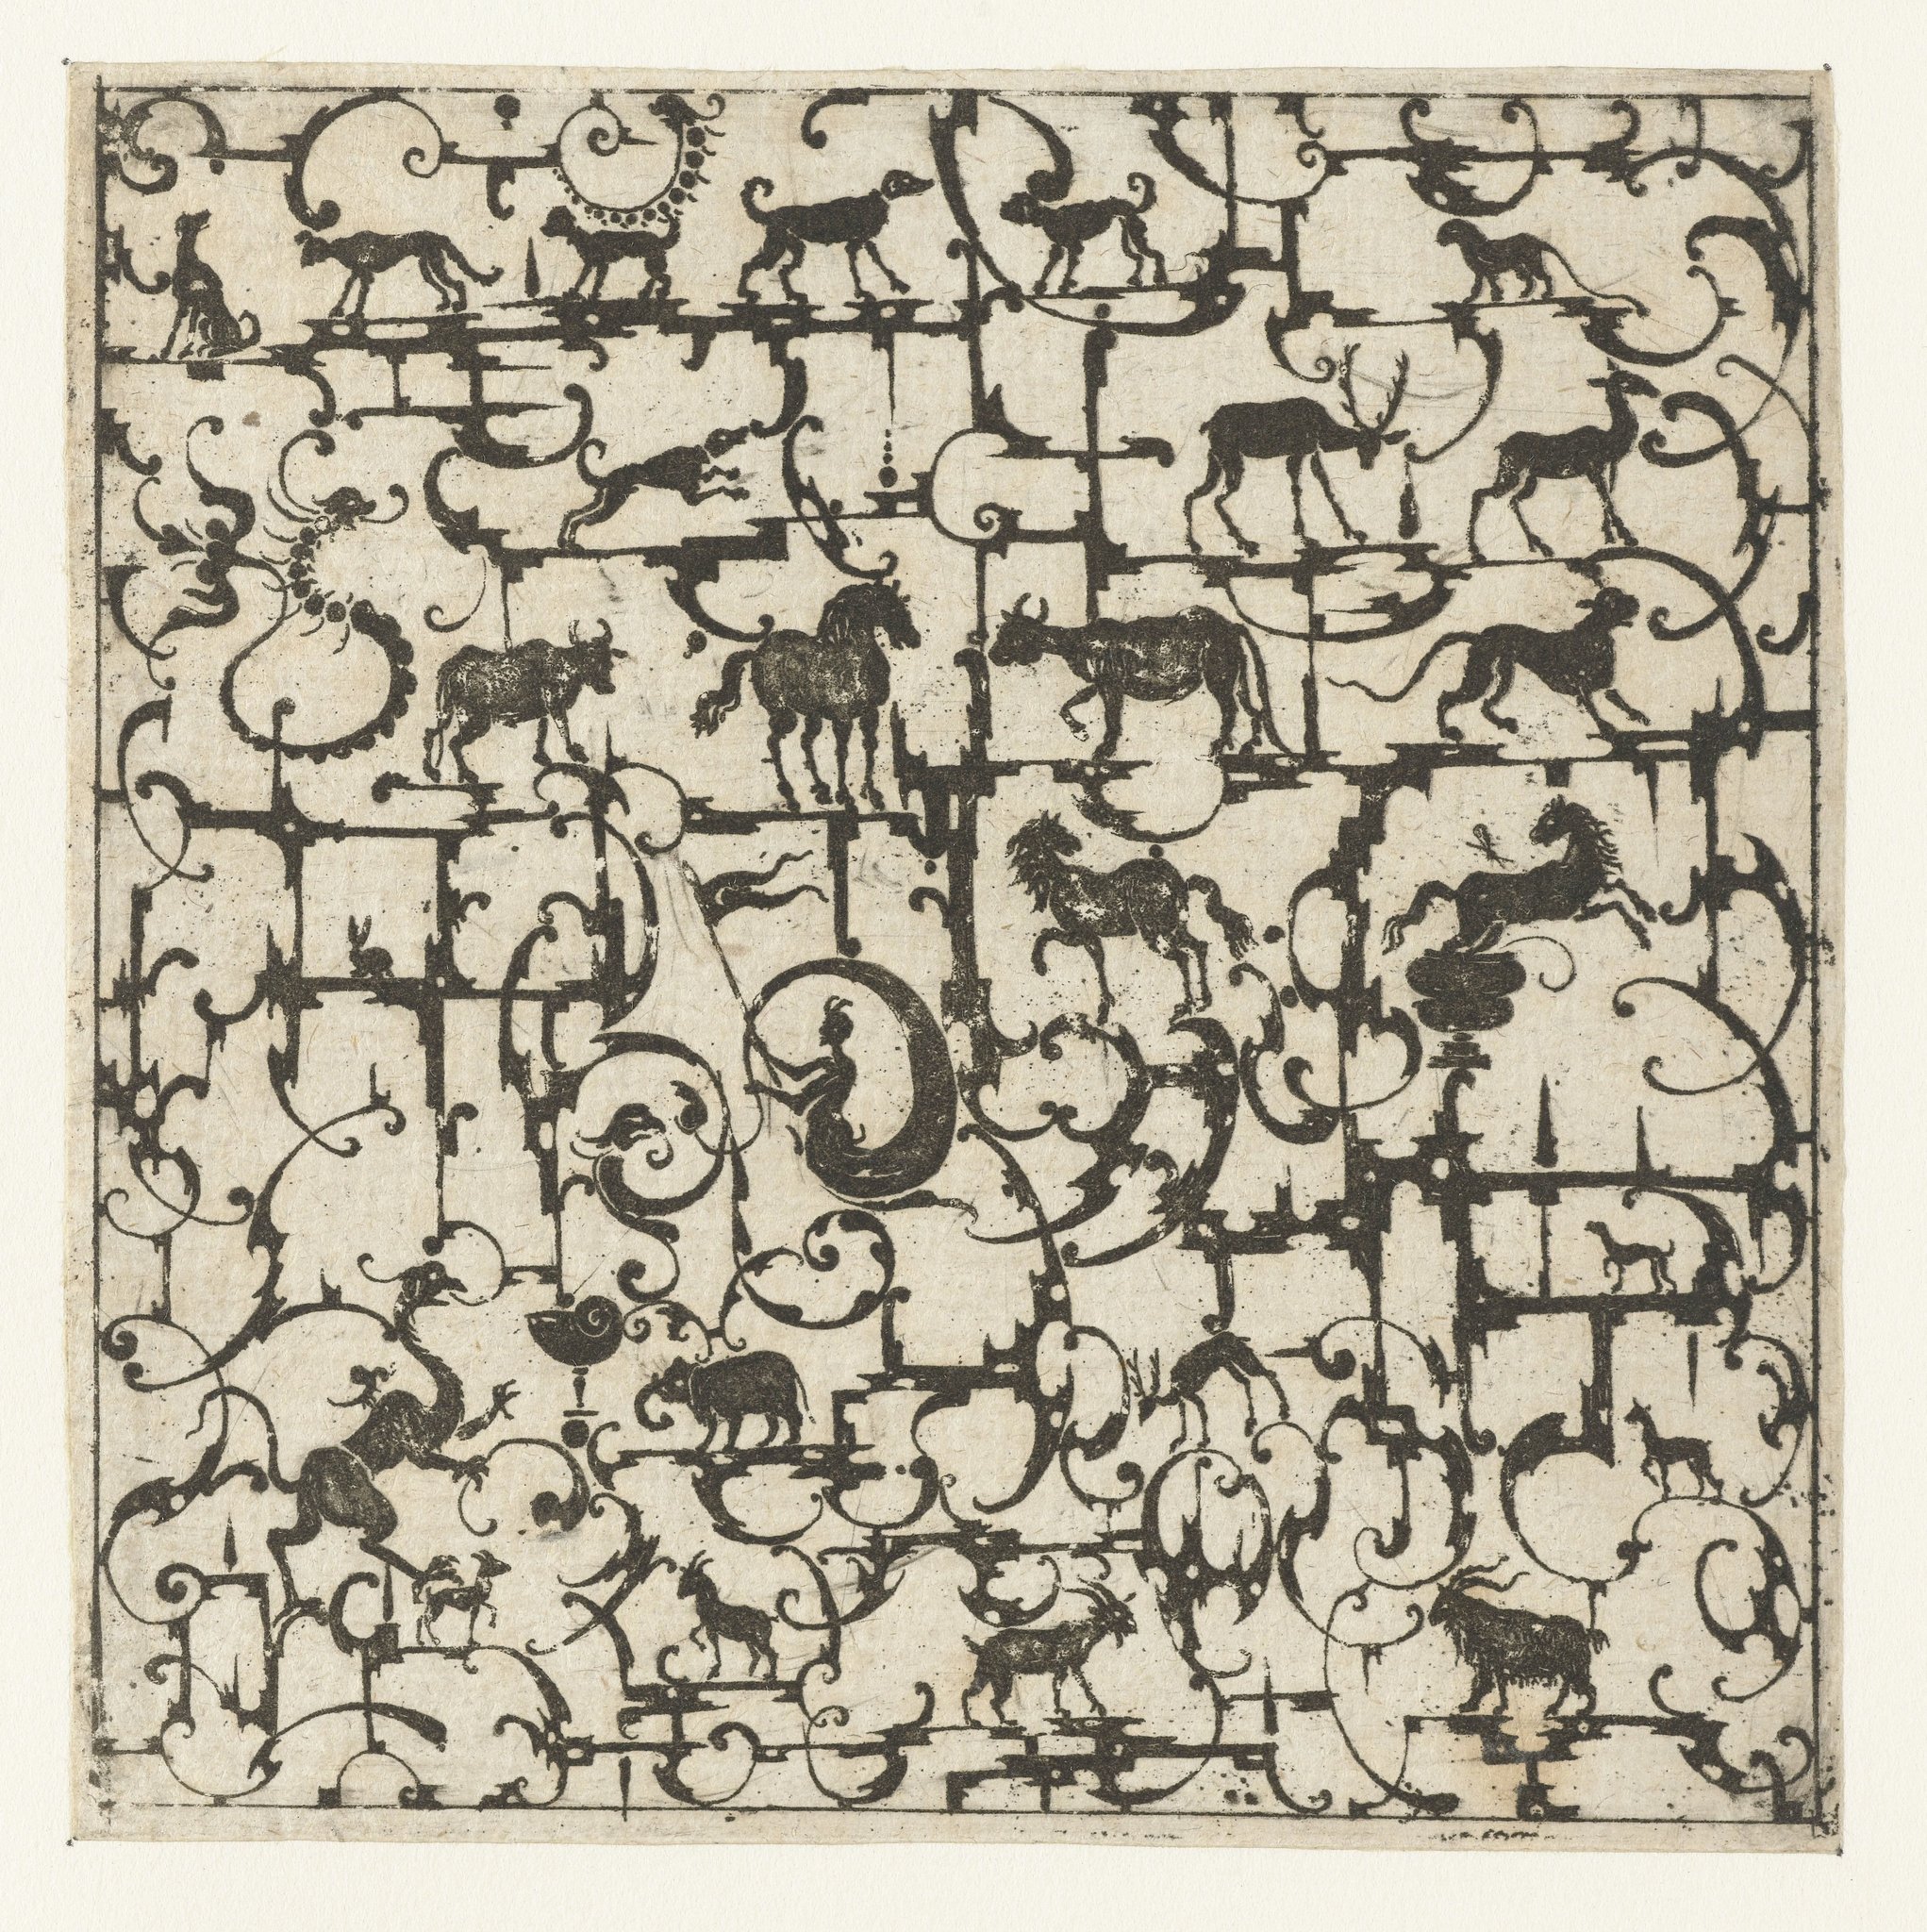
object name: print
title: Schweifwerk ornamenten voor edelsmeden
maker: esaias van hulsen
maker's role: engineer, goldsmith, print maker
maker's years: 1570-1626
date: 1617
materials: paper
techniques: etching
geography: stuttgart